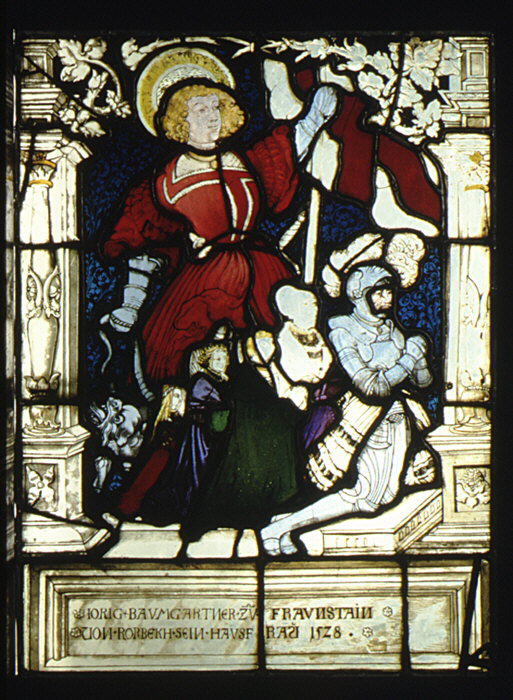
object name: panel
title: St. George standing behind kneeling donor, Jorig Baumgartner, and his family (one of a pair)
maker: hans wertinger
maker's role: artist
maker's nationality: german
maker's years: 1465-1533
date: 1528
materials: glass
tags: saint george